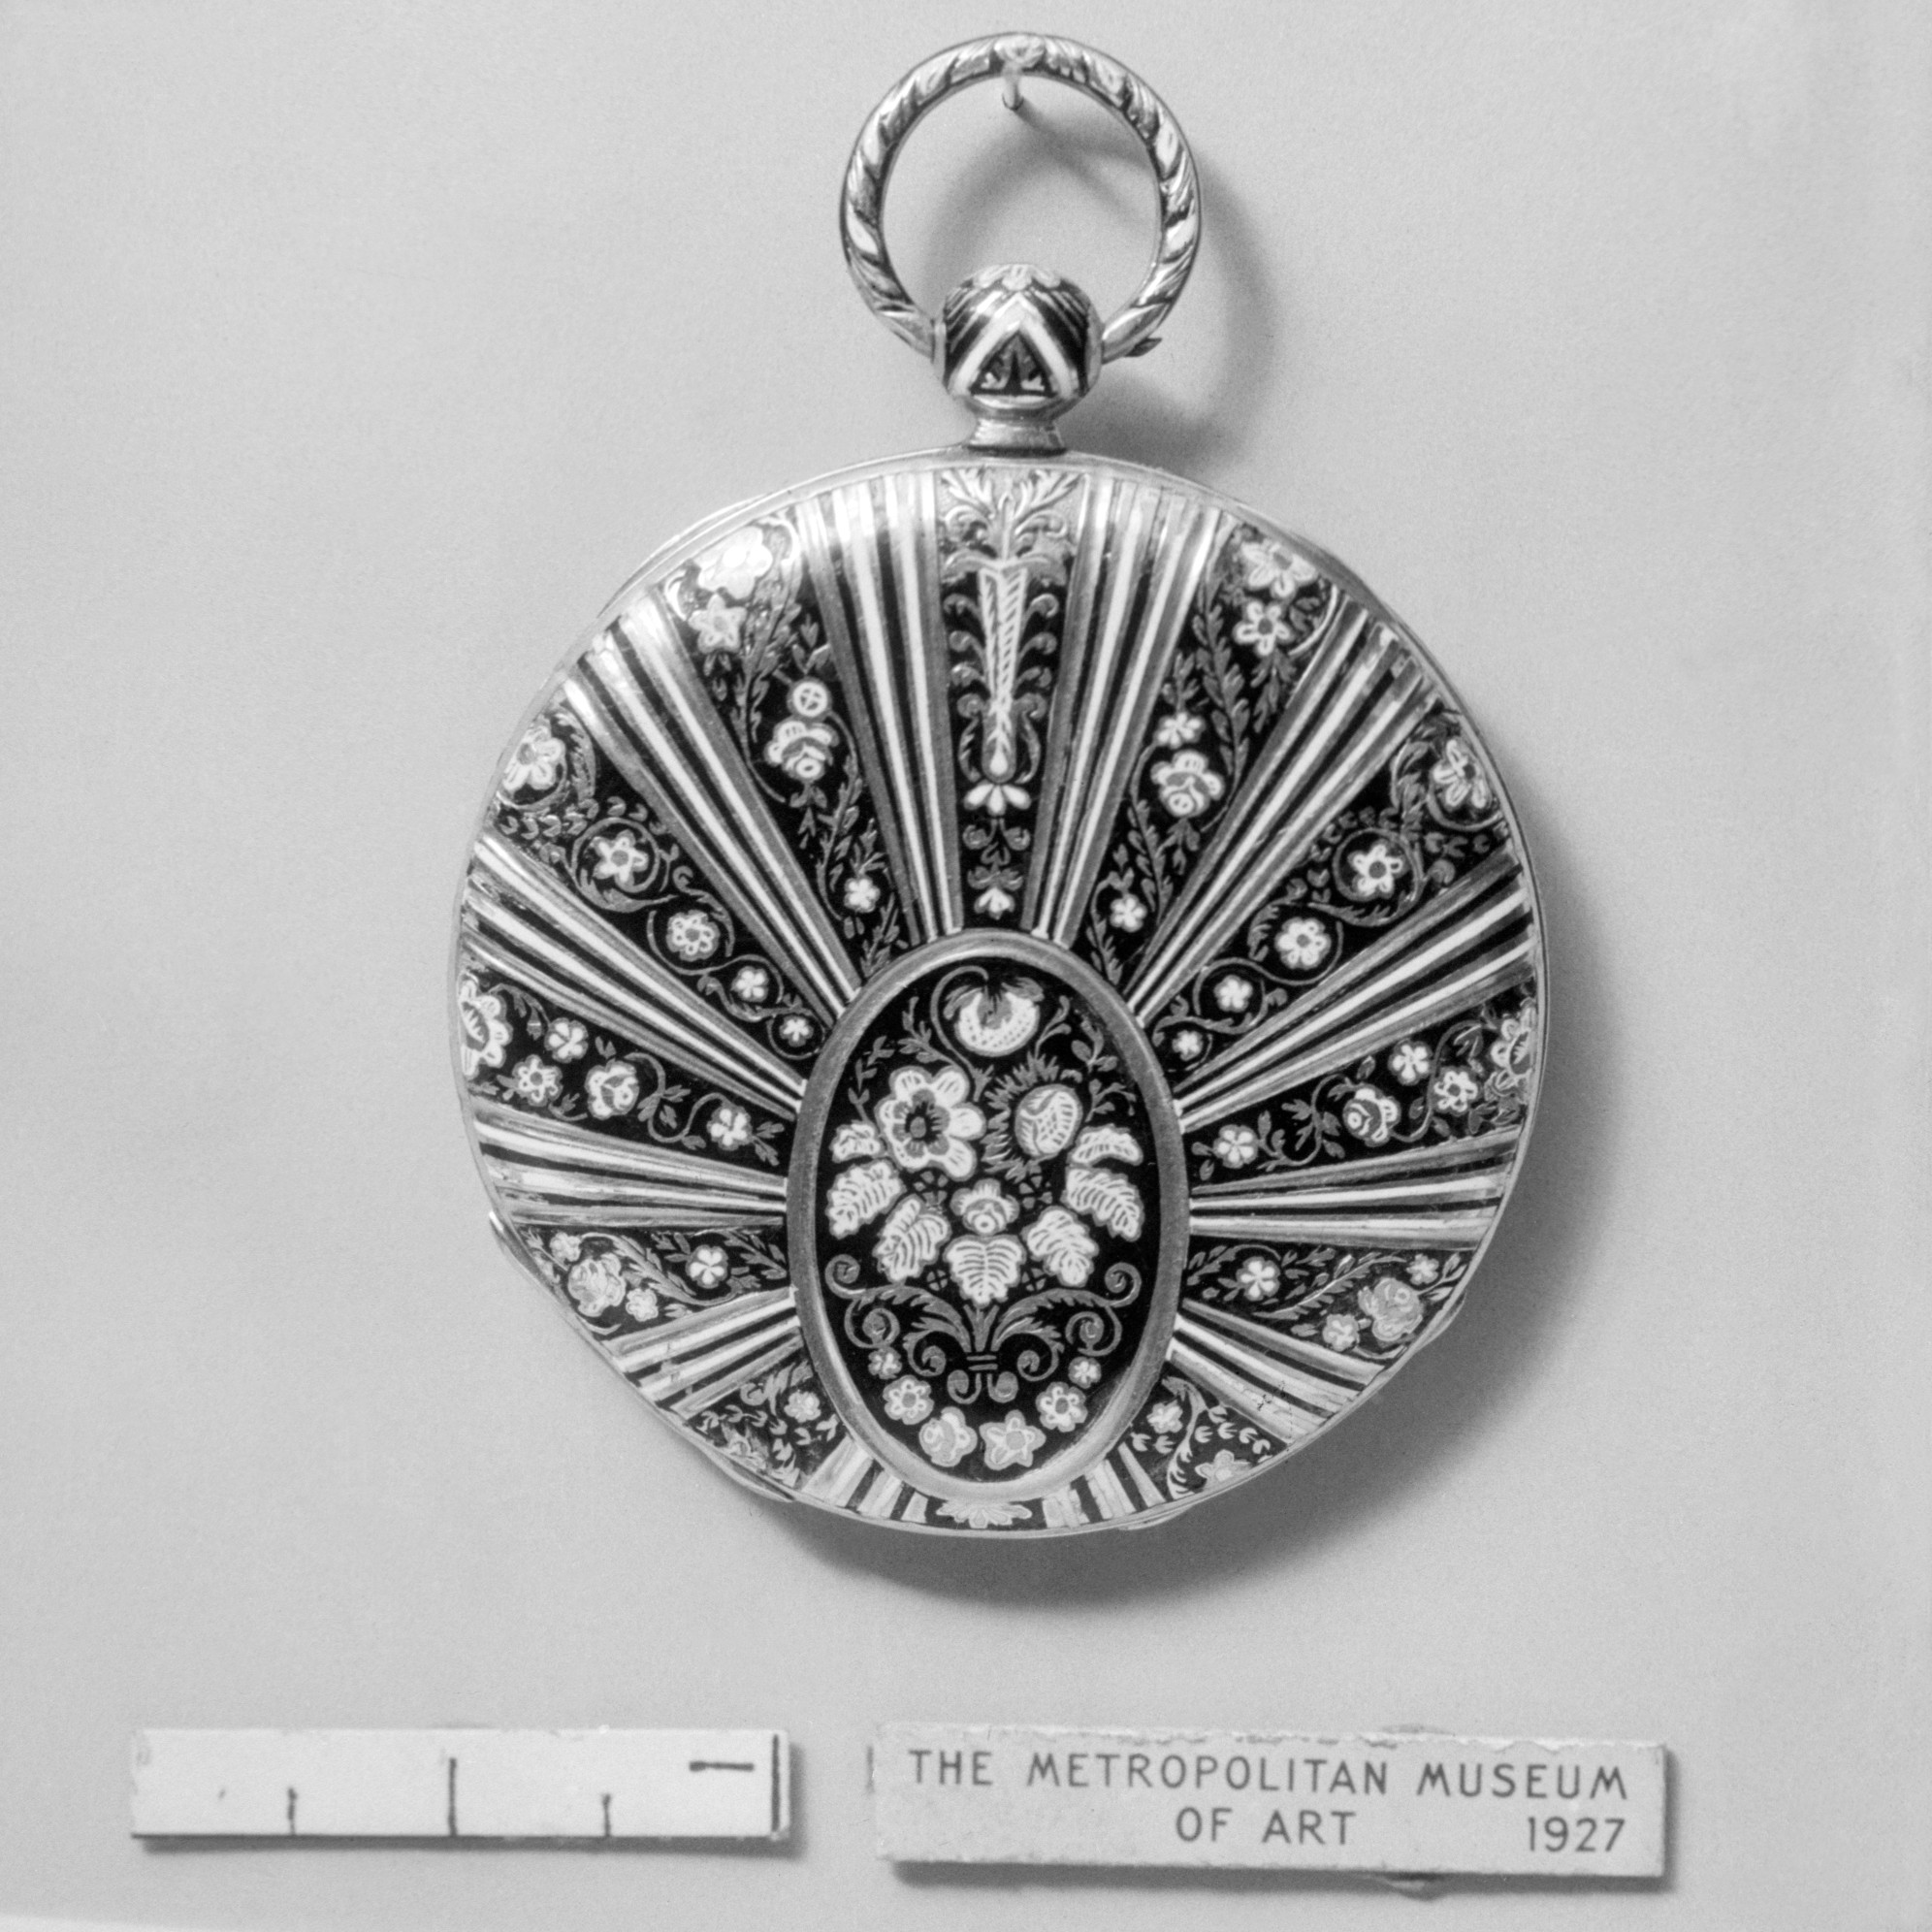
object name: watch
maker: firm of moricand & degrange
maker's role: maker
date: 1835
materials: enamel, gold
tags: flowers